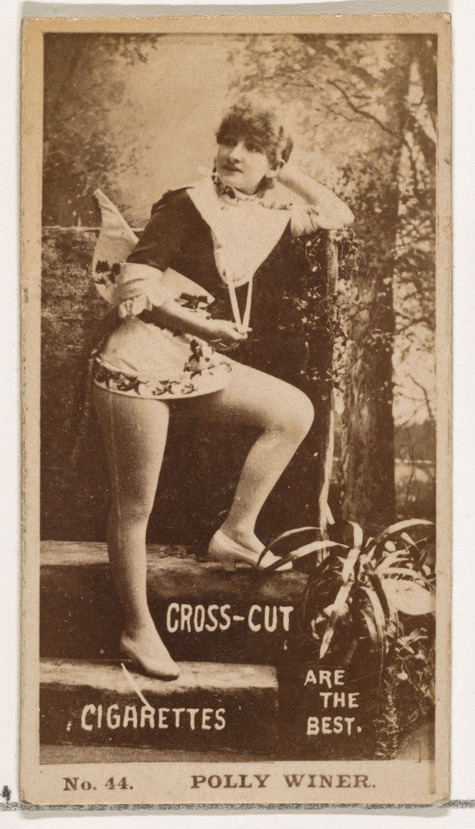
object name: print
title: Card Number 44, Polly Winer, from the Actors and Actresses series (N145-2) issued by Duke Sons & Co. to promote Cross Cut Cigarettes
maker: w. duke, sons & co.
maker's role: publisher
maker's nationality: american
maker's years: 1870-1920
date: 1880-1889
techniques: albumen silver print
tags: portraits,women,actresses